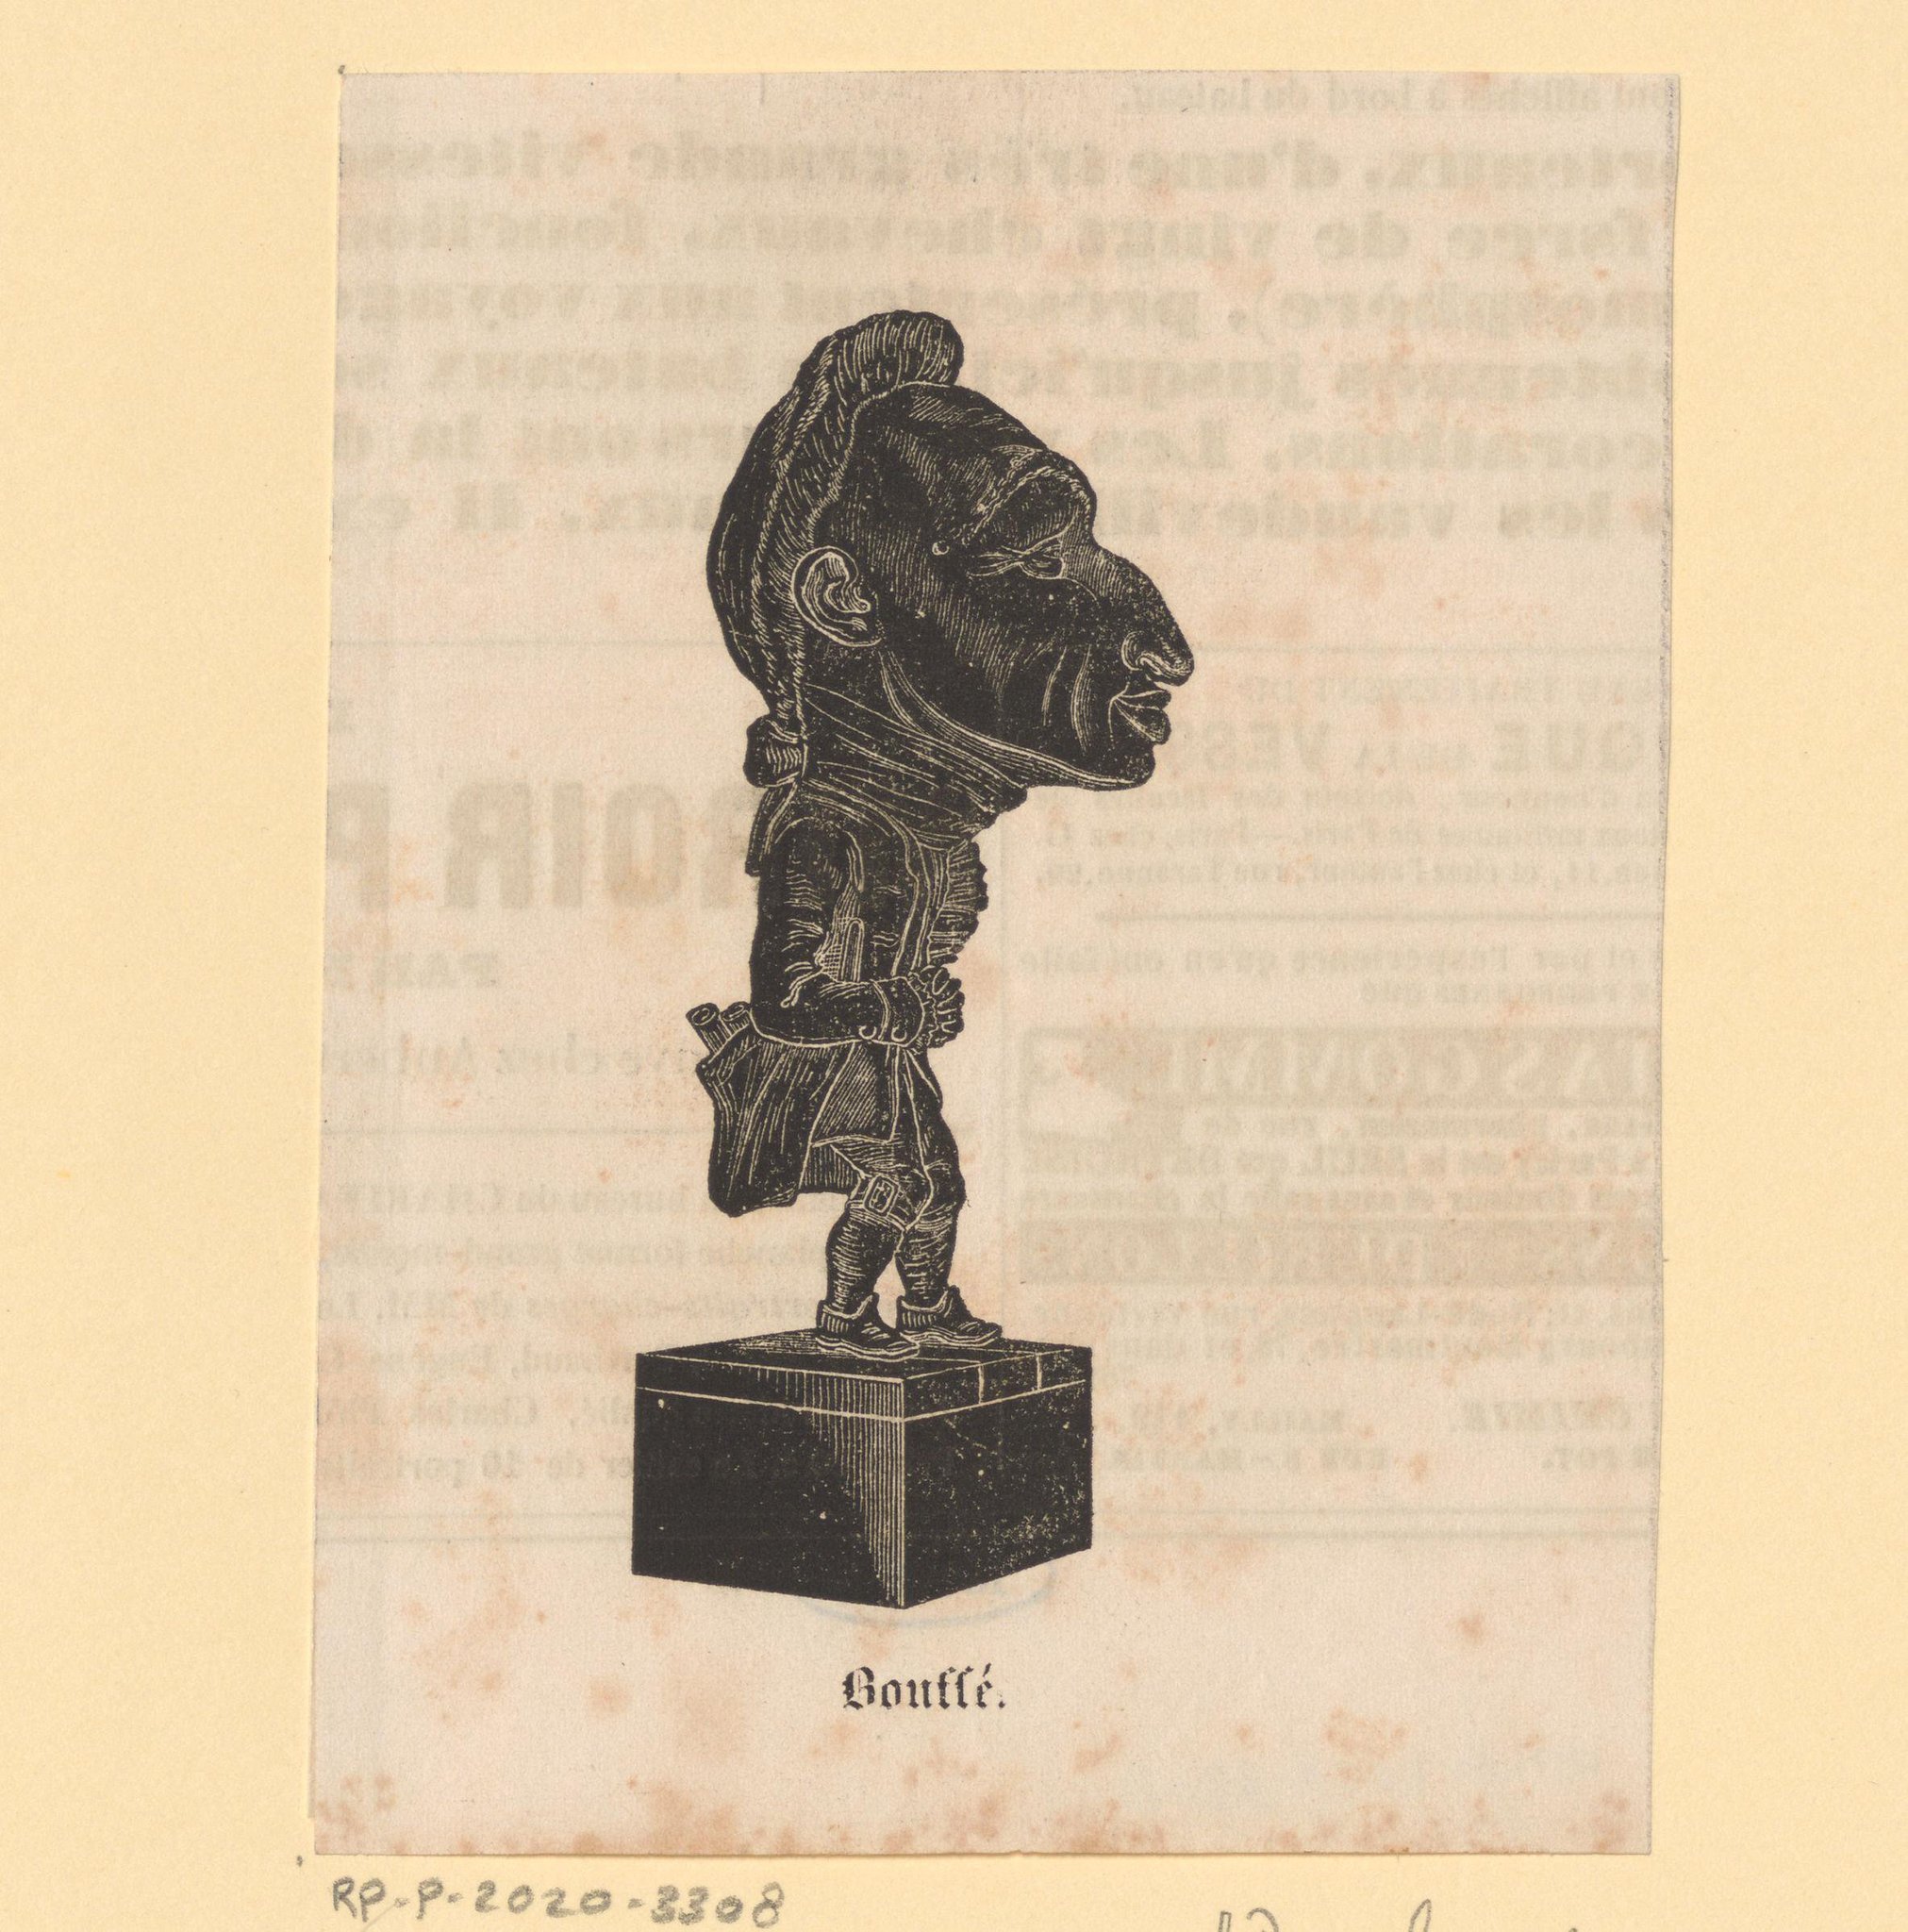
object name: cartoon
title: Karikaturaal portret van Hugues Bouffé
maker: Anonymous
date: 1833-1850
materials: paper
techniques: letterpress printing, engraving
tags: historical persons, portrait of actor, actress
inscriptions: collector's mark: Lugt 2228